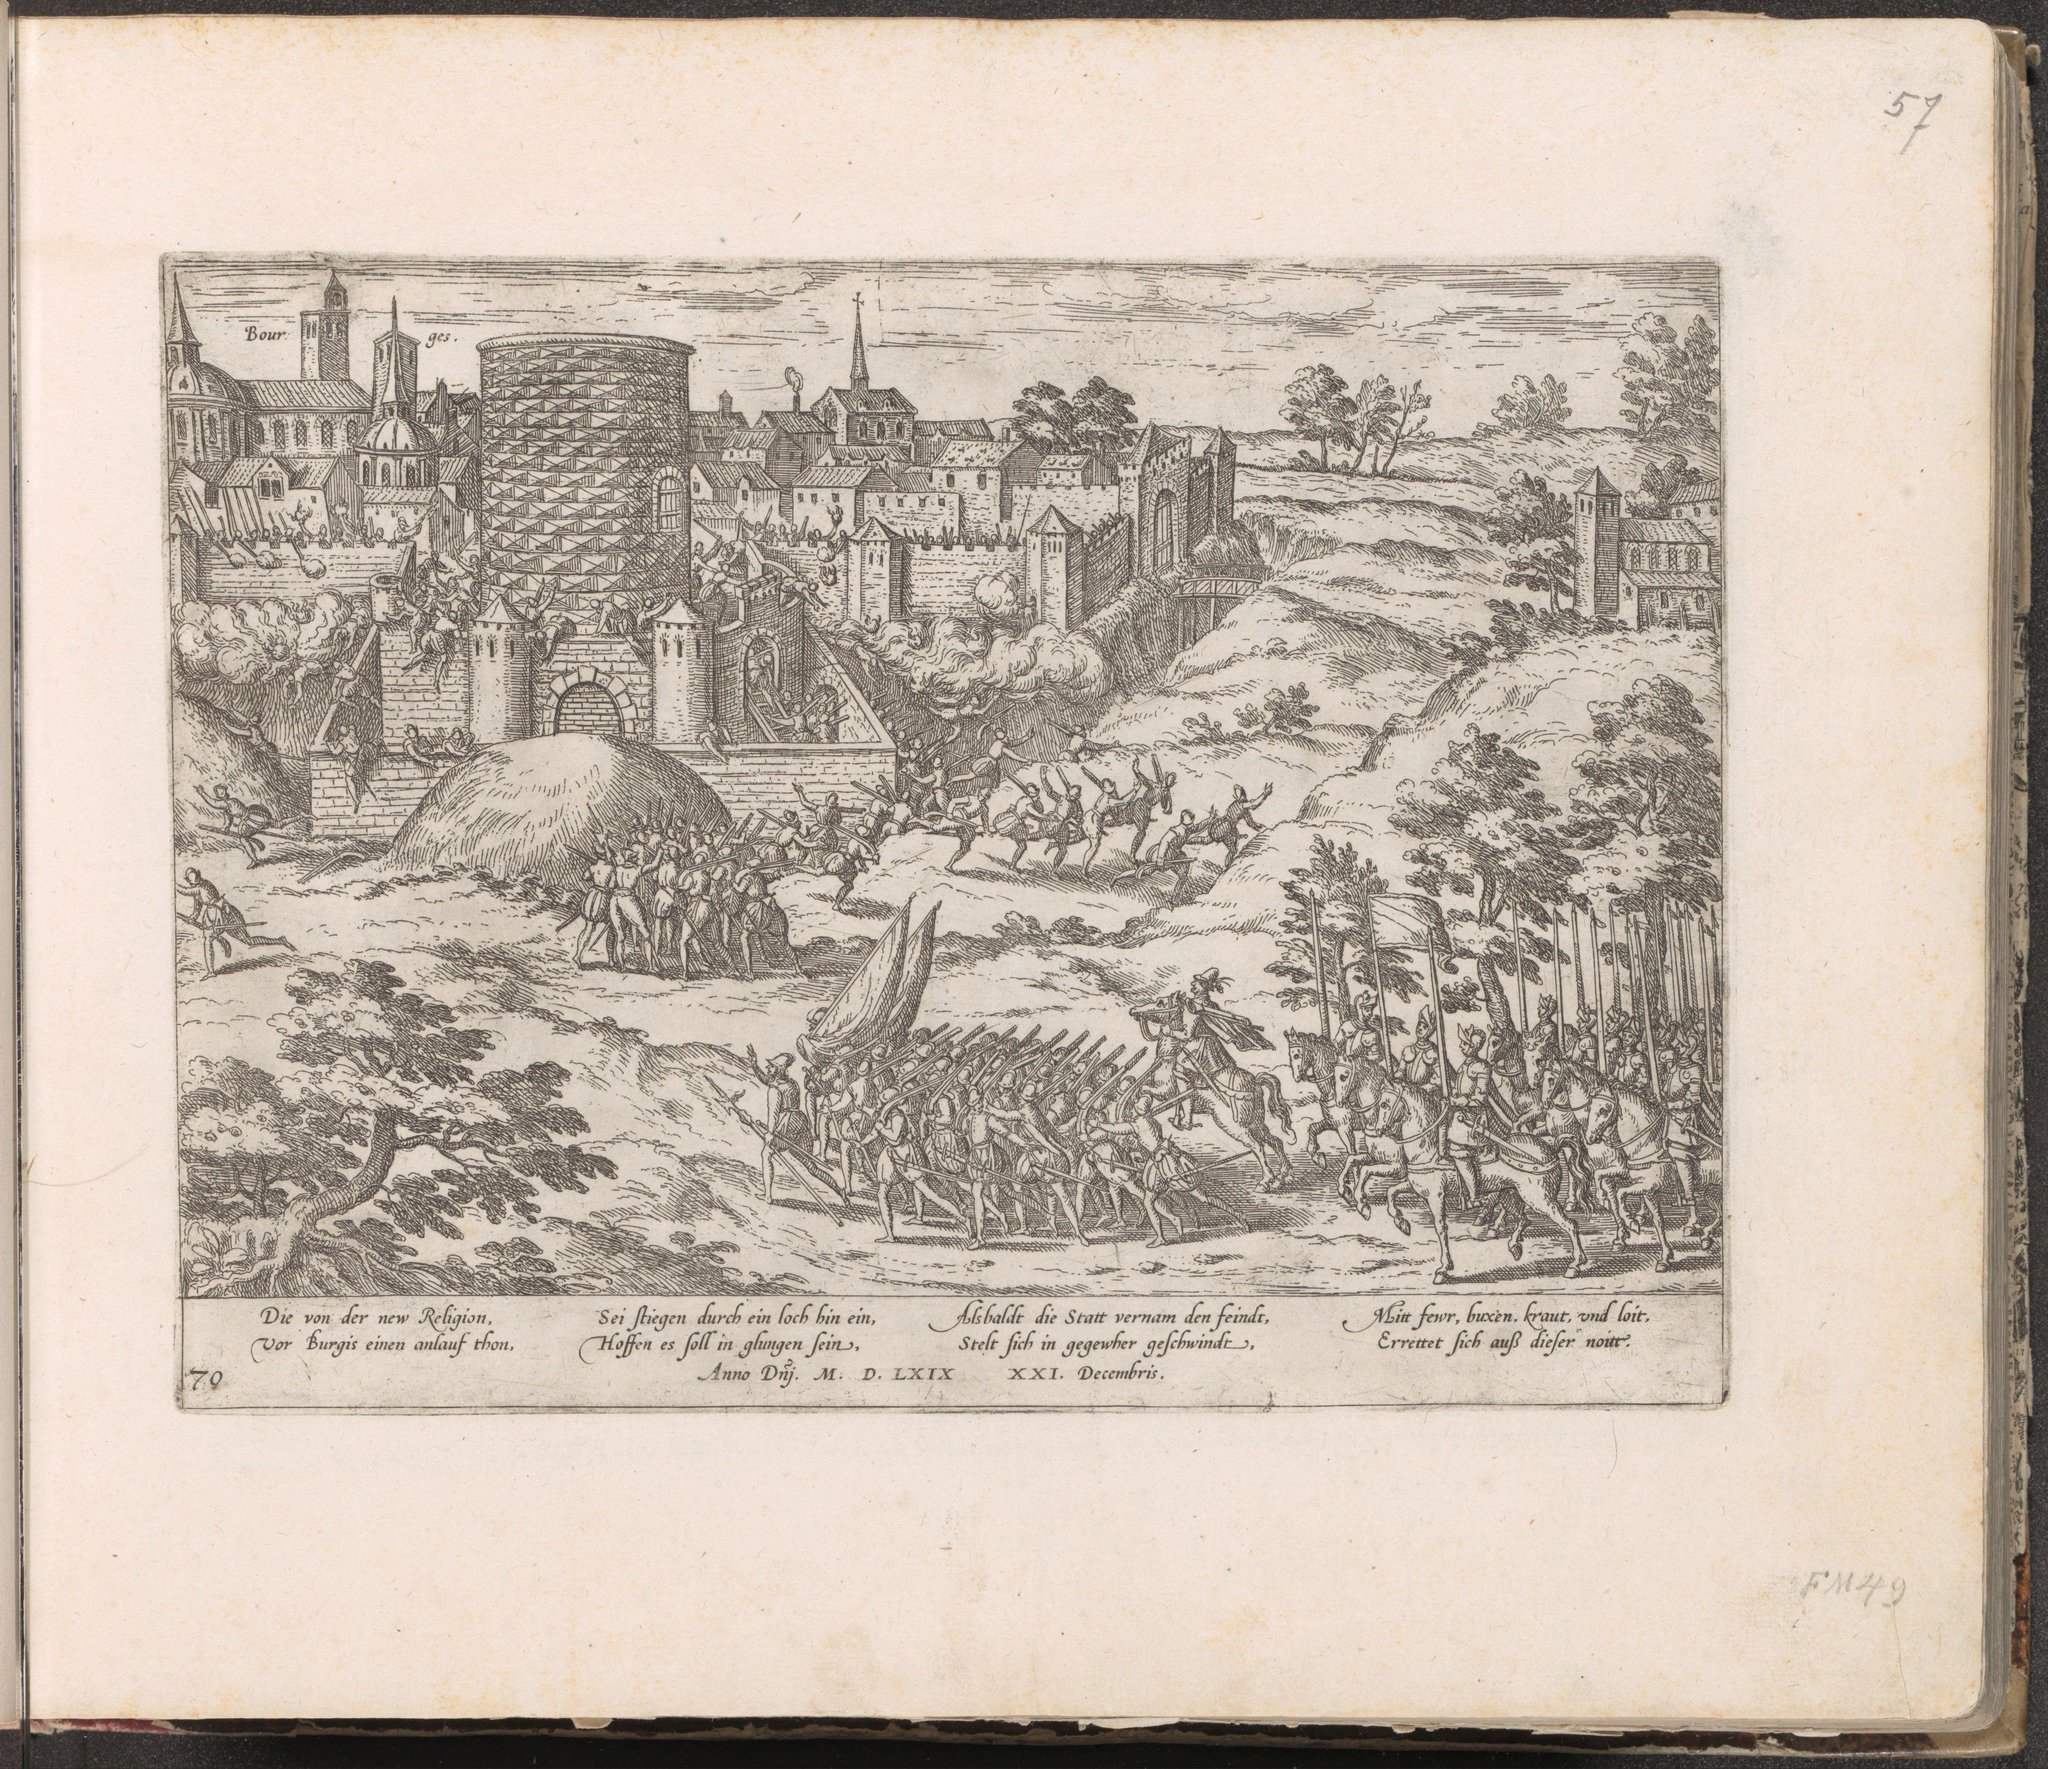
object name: history print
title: Serie 3: Franse Godsdienstoorlogen, 1559-1573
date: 1569-1571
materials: paper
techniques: etching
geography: cologne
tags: siege, position war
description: Aanslag door de hugenoten op Bourges verijdeld, 21 december 1569. Gezicht op de stad waarbij de aanval van de protestantse troepen wordt afgeslagen. Met onderschrift van 8 regels in het Duits. Linksonder genummerd: 70. De prent maakt deel uit van een album.